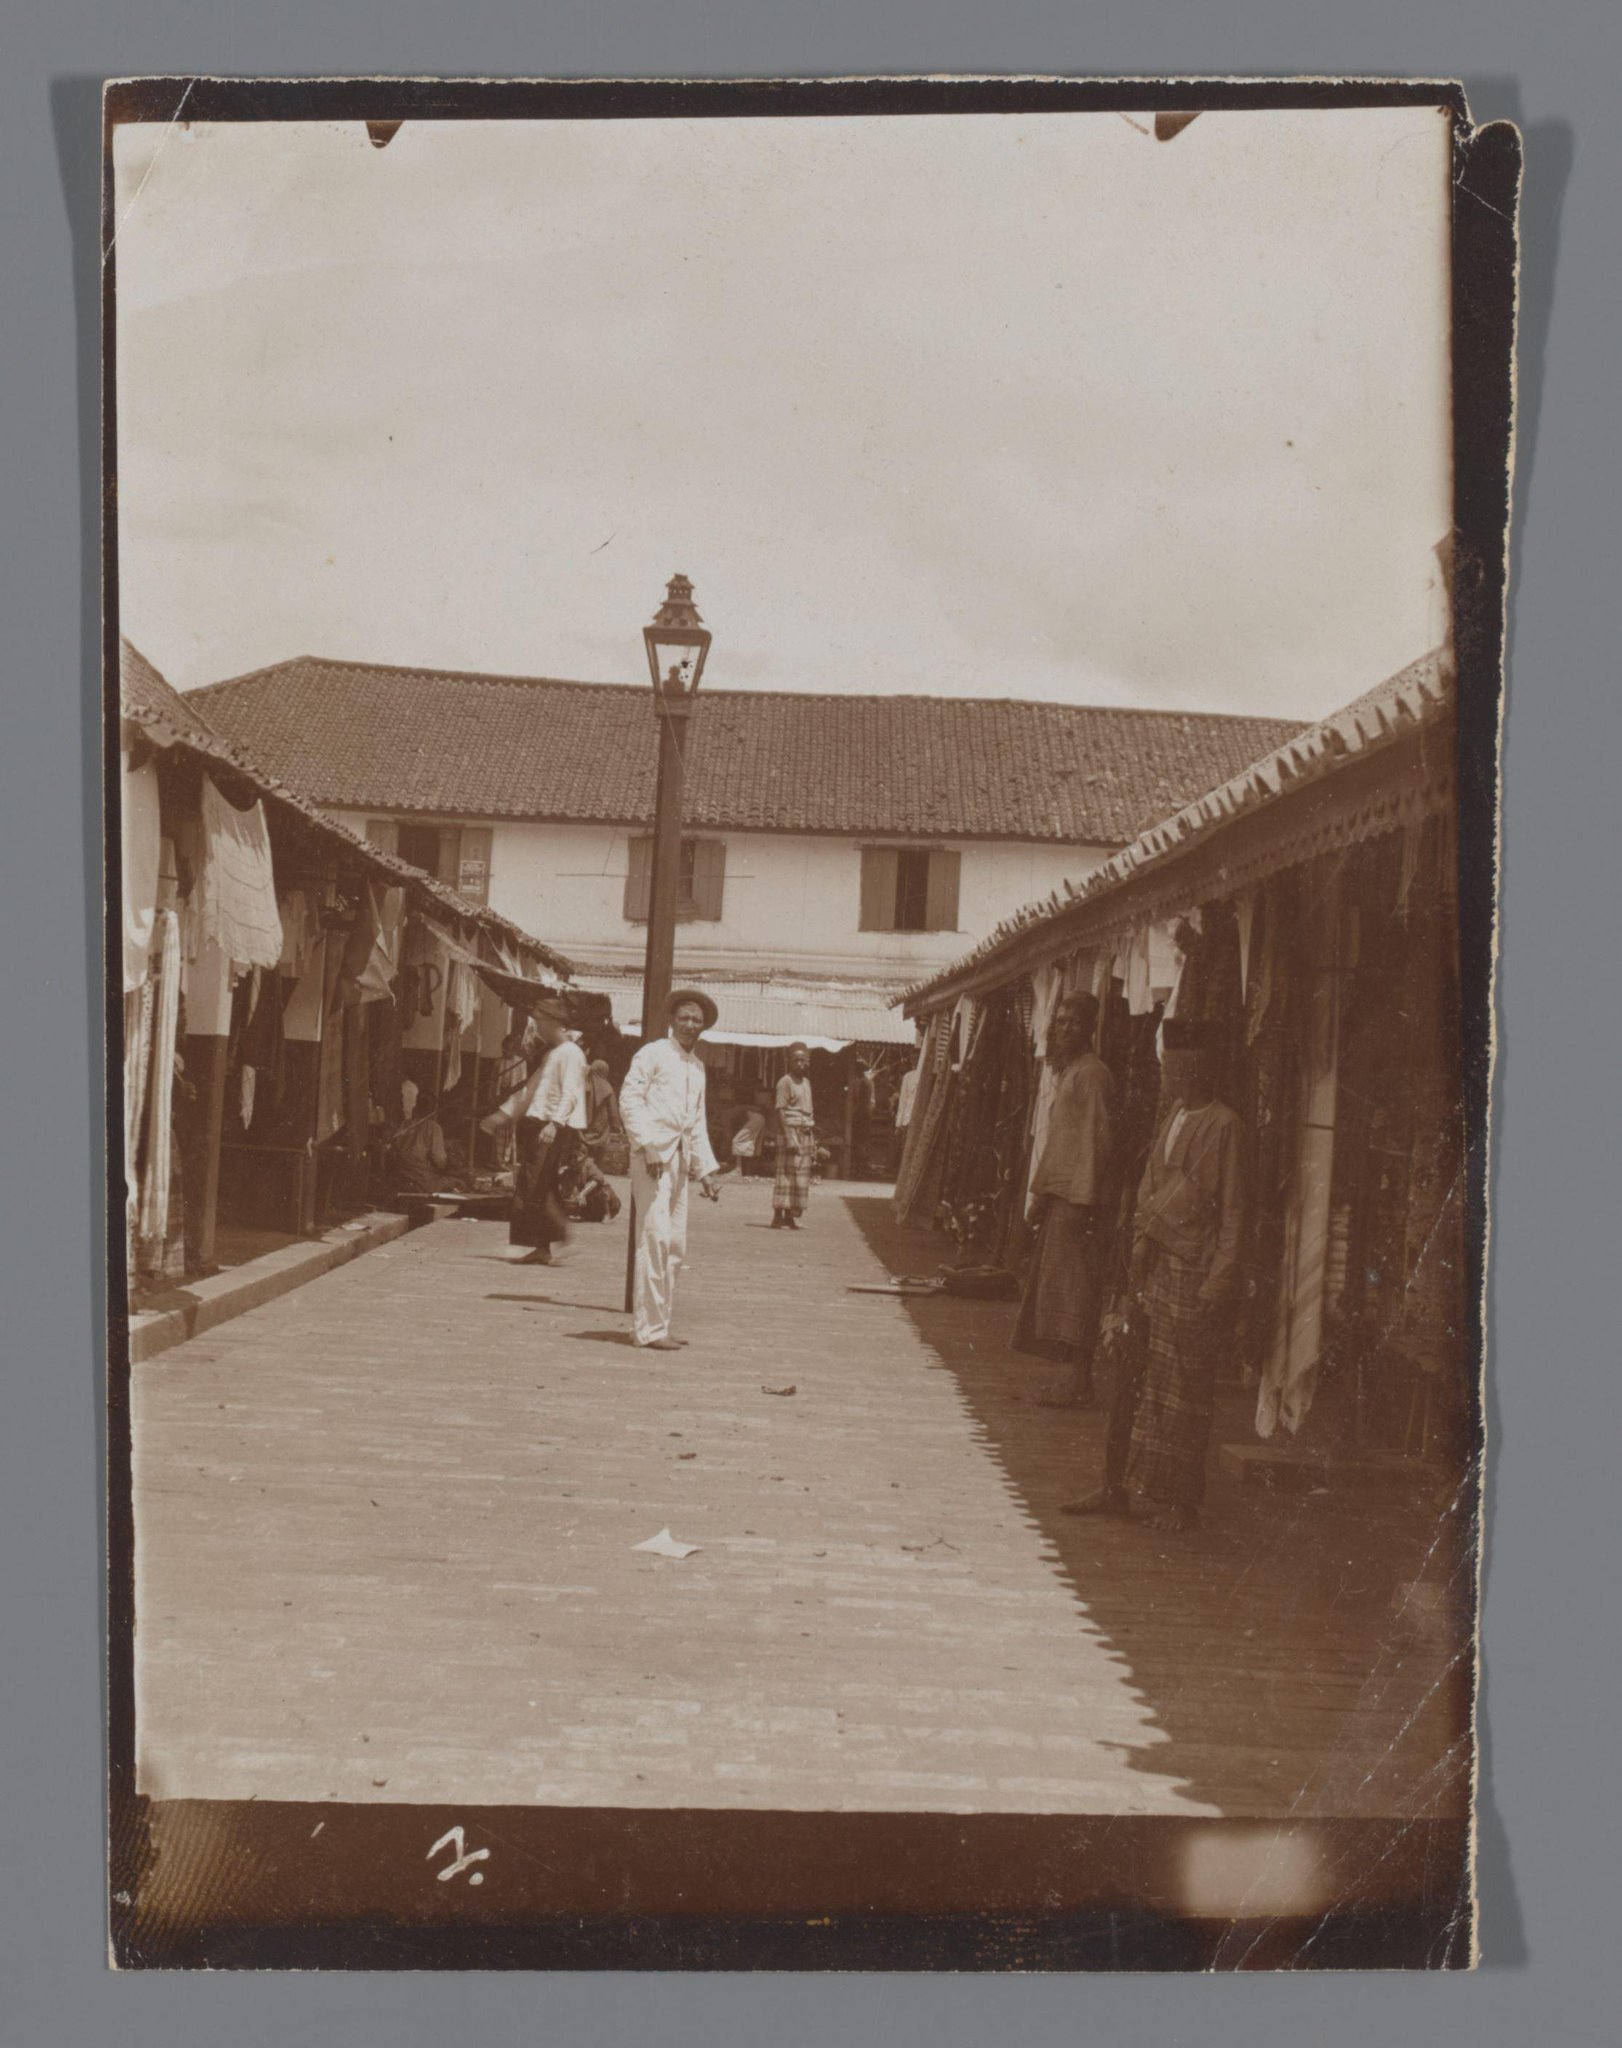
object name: photograph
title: Winkelstraat met kledingstalletjes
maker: Anonymous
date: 1900-1940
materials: photographic support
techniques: collodion silver print, gelatin silver print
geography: sumatra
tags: sumatra, dutch east indies, the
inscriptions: inscription: ‘1.’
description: Winkelstraat met kledingstalletjes, mogelijk te Medan. Onderdeel van een groep van 14 losse foto's genomen op Midden- en Zuid-Sumatra in de periode ca. 1900-1940.